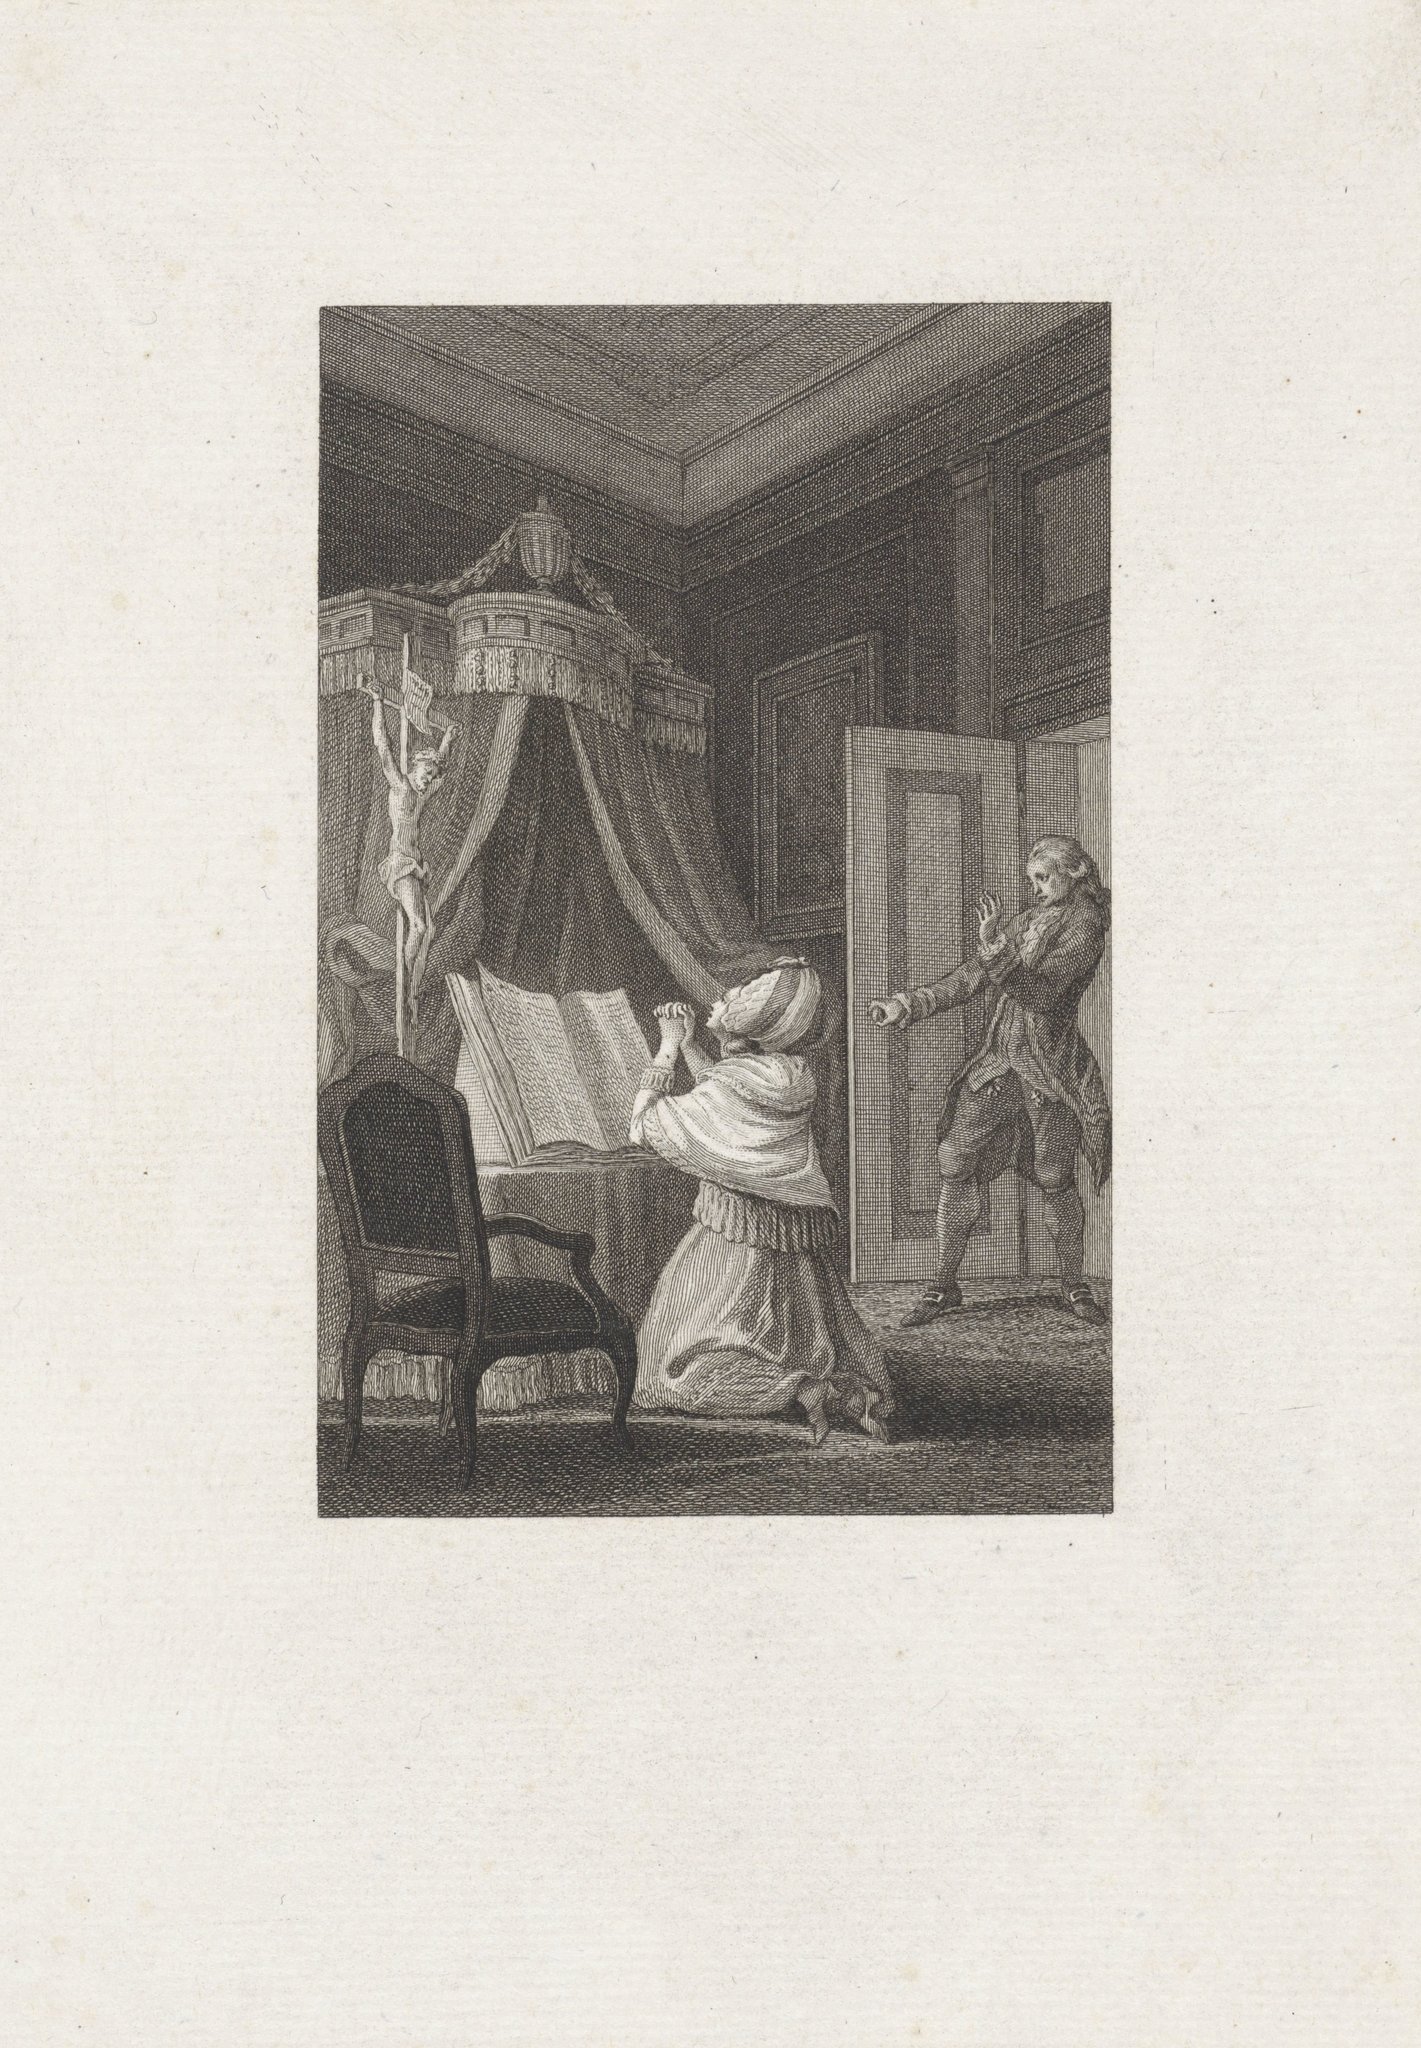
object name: print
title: Vrouw biddend voor een crucifix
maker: reinier vinkeles (i)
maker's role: draughtsman, print maker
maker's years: 1741-1816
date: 1779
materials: paper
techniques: engraving, etching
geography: amsterdam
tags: crucifix ~ personal devotion, one person praying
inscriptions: collector's mark: Lugt 240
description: Proefdruk van illustratie bij het verhaal Louise uit: Baculard d'Arnaud, François Thomas Marie de. Zedelyke verhaalen. Amsterdam: Anthony Mens Jansz. en A.E. Munnikhuisen, 1779.